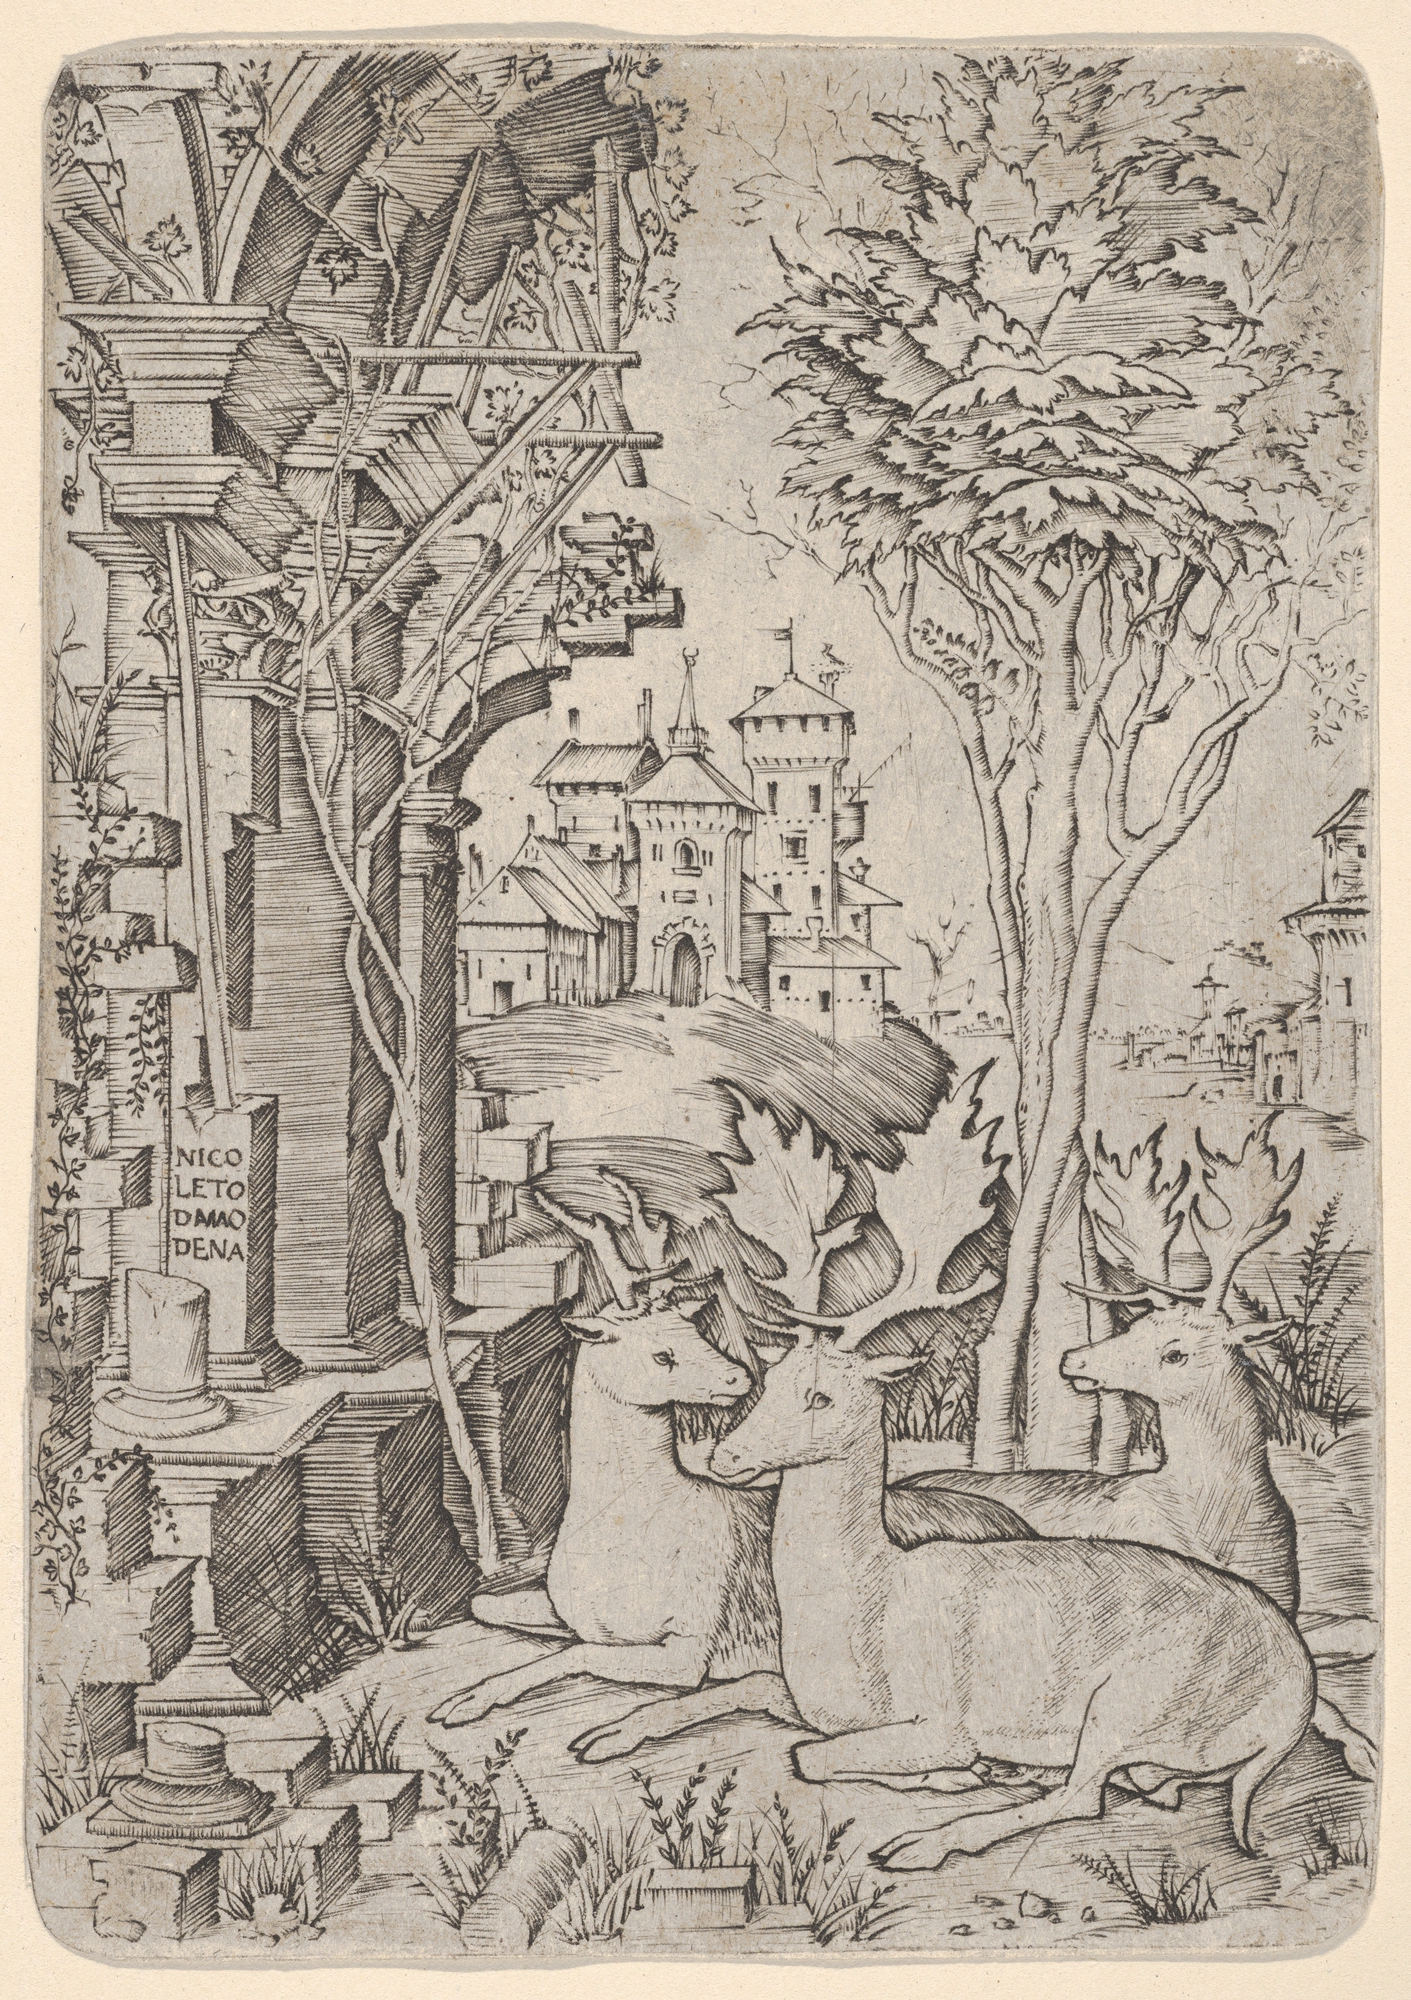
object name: print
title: Three Stags, sitting in the ground, buildings in background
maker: nicoletto da modena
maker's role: artist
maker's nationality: italian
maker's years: 1500-1520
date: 1500-1510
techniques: engraving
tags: buildings,deer,trees